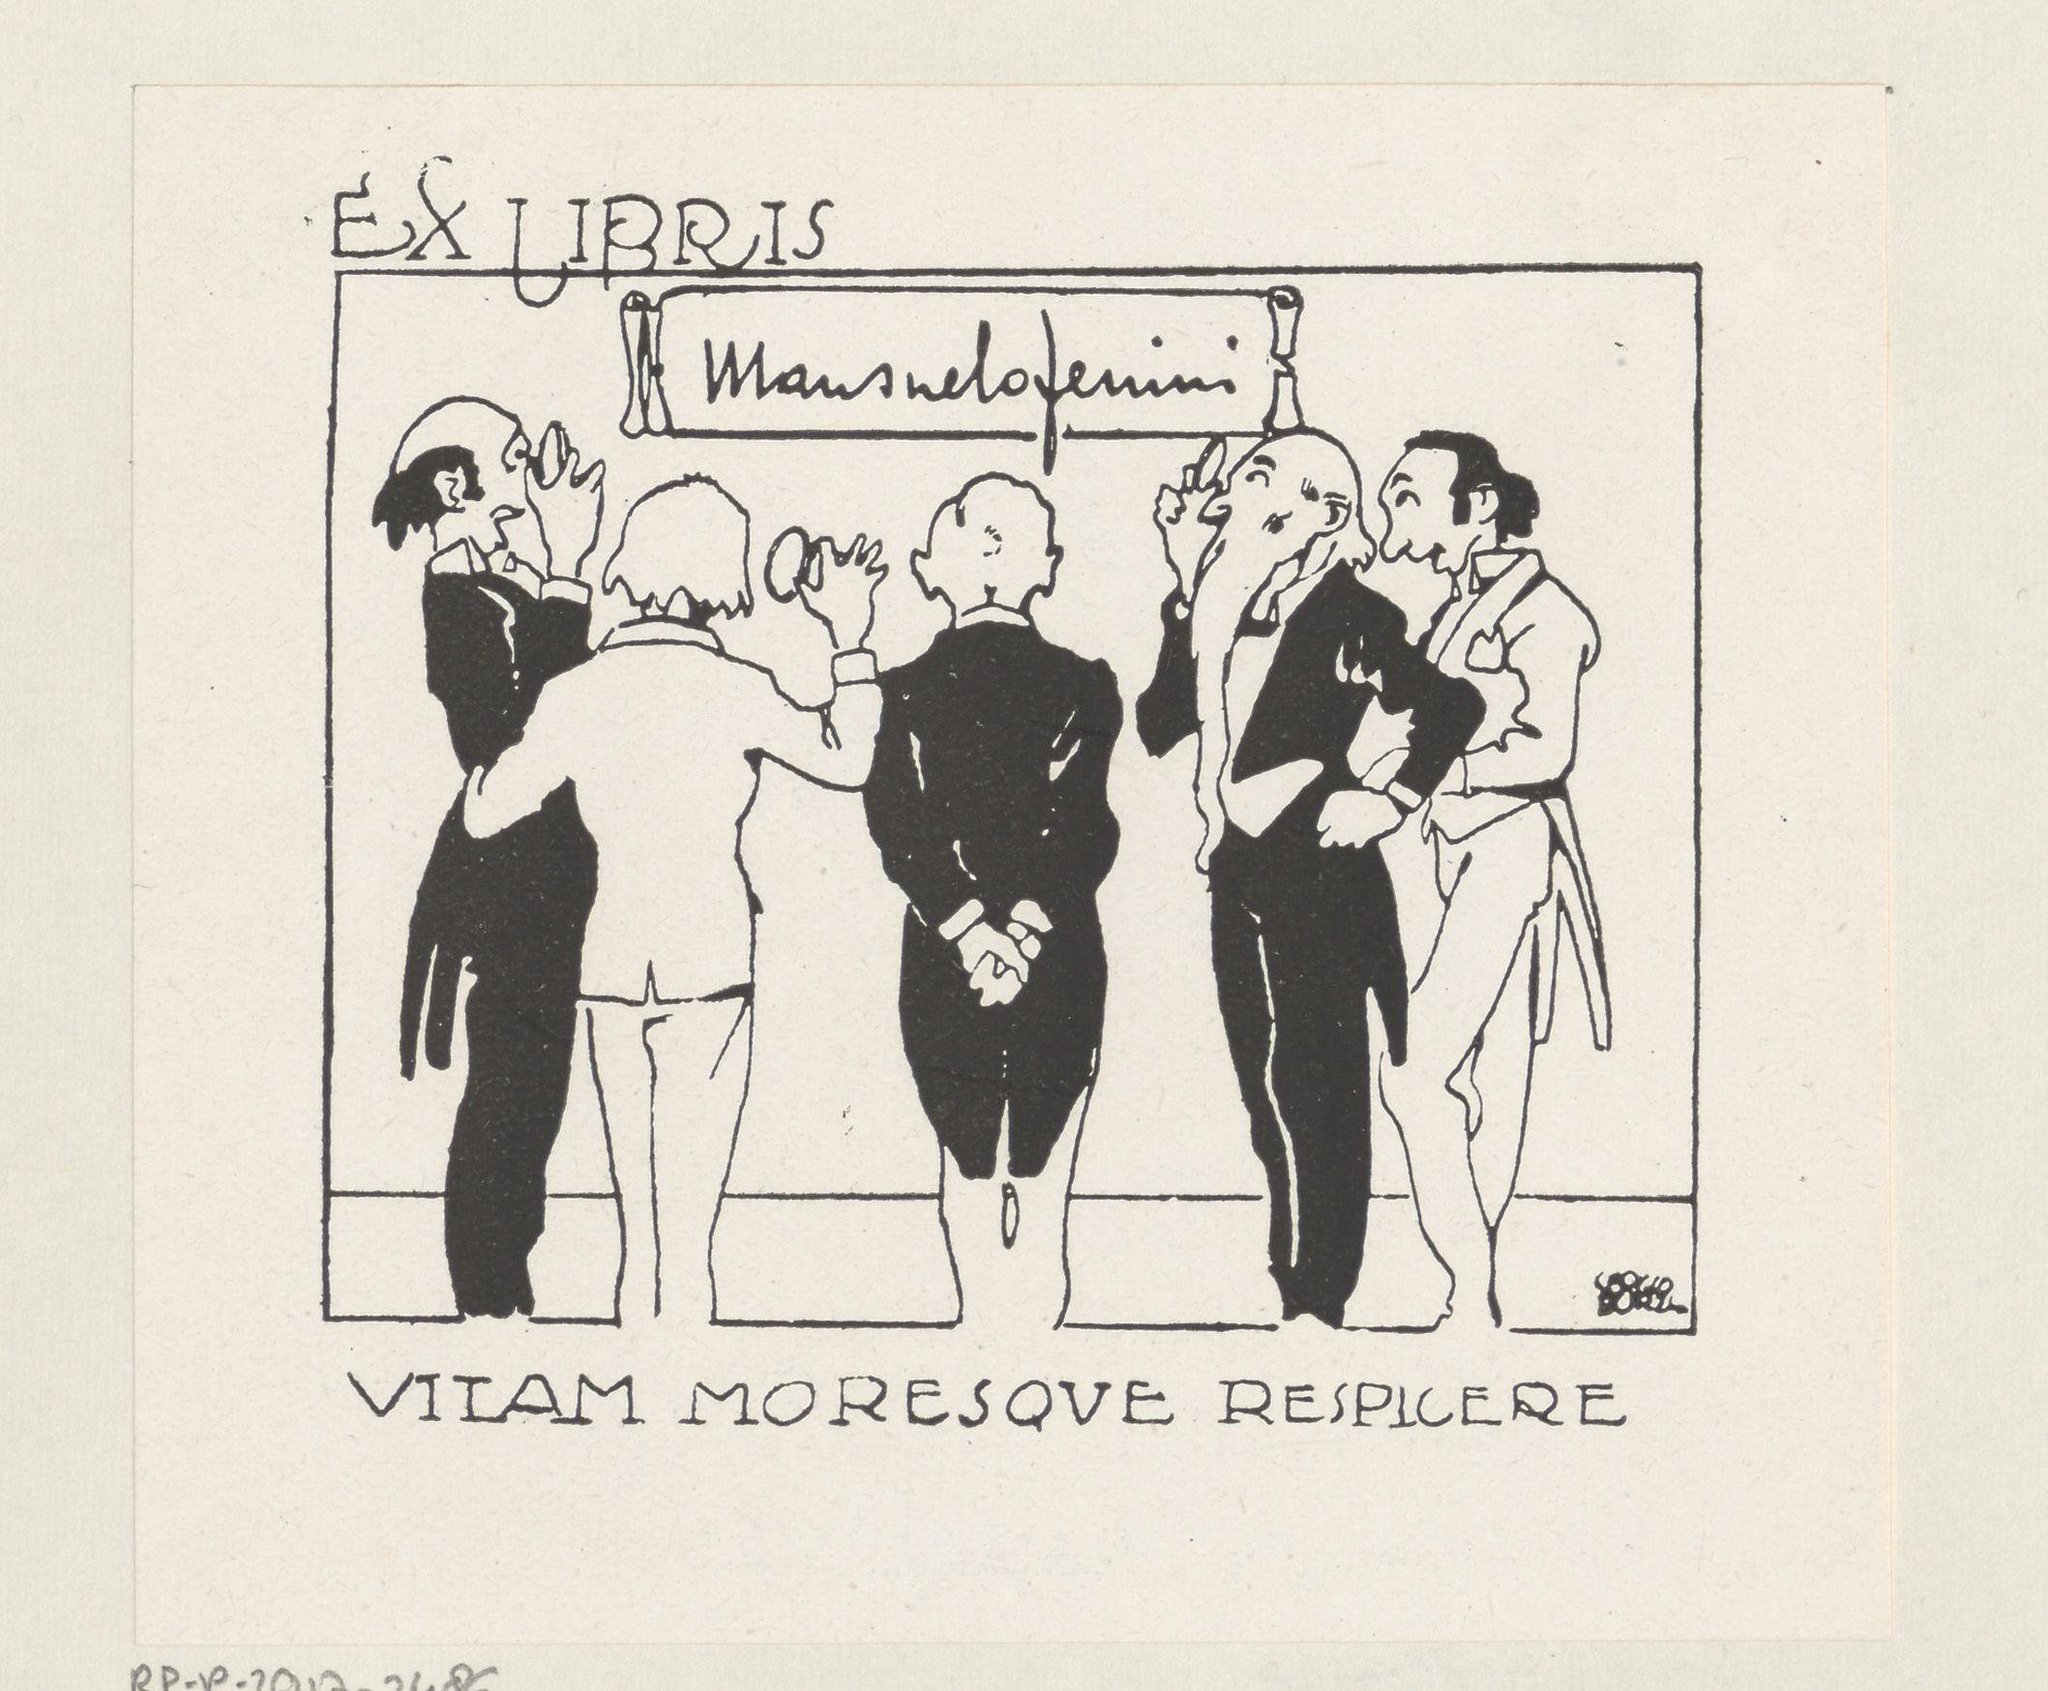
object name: bookplate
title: Ex libris van Mansueto Fenini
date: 1911-1954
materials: paper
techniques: printing block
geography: italy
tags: old man, magnifying glass